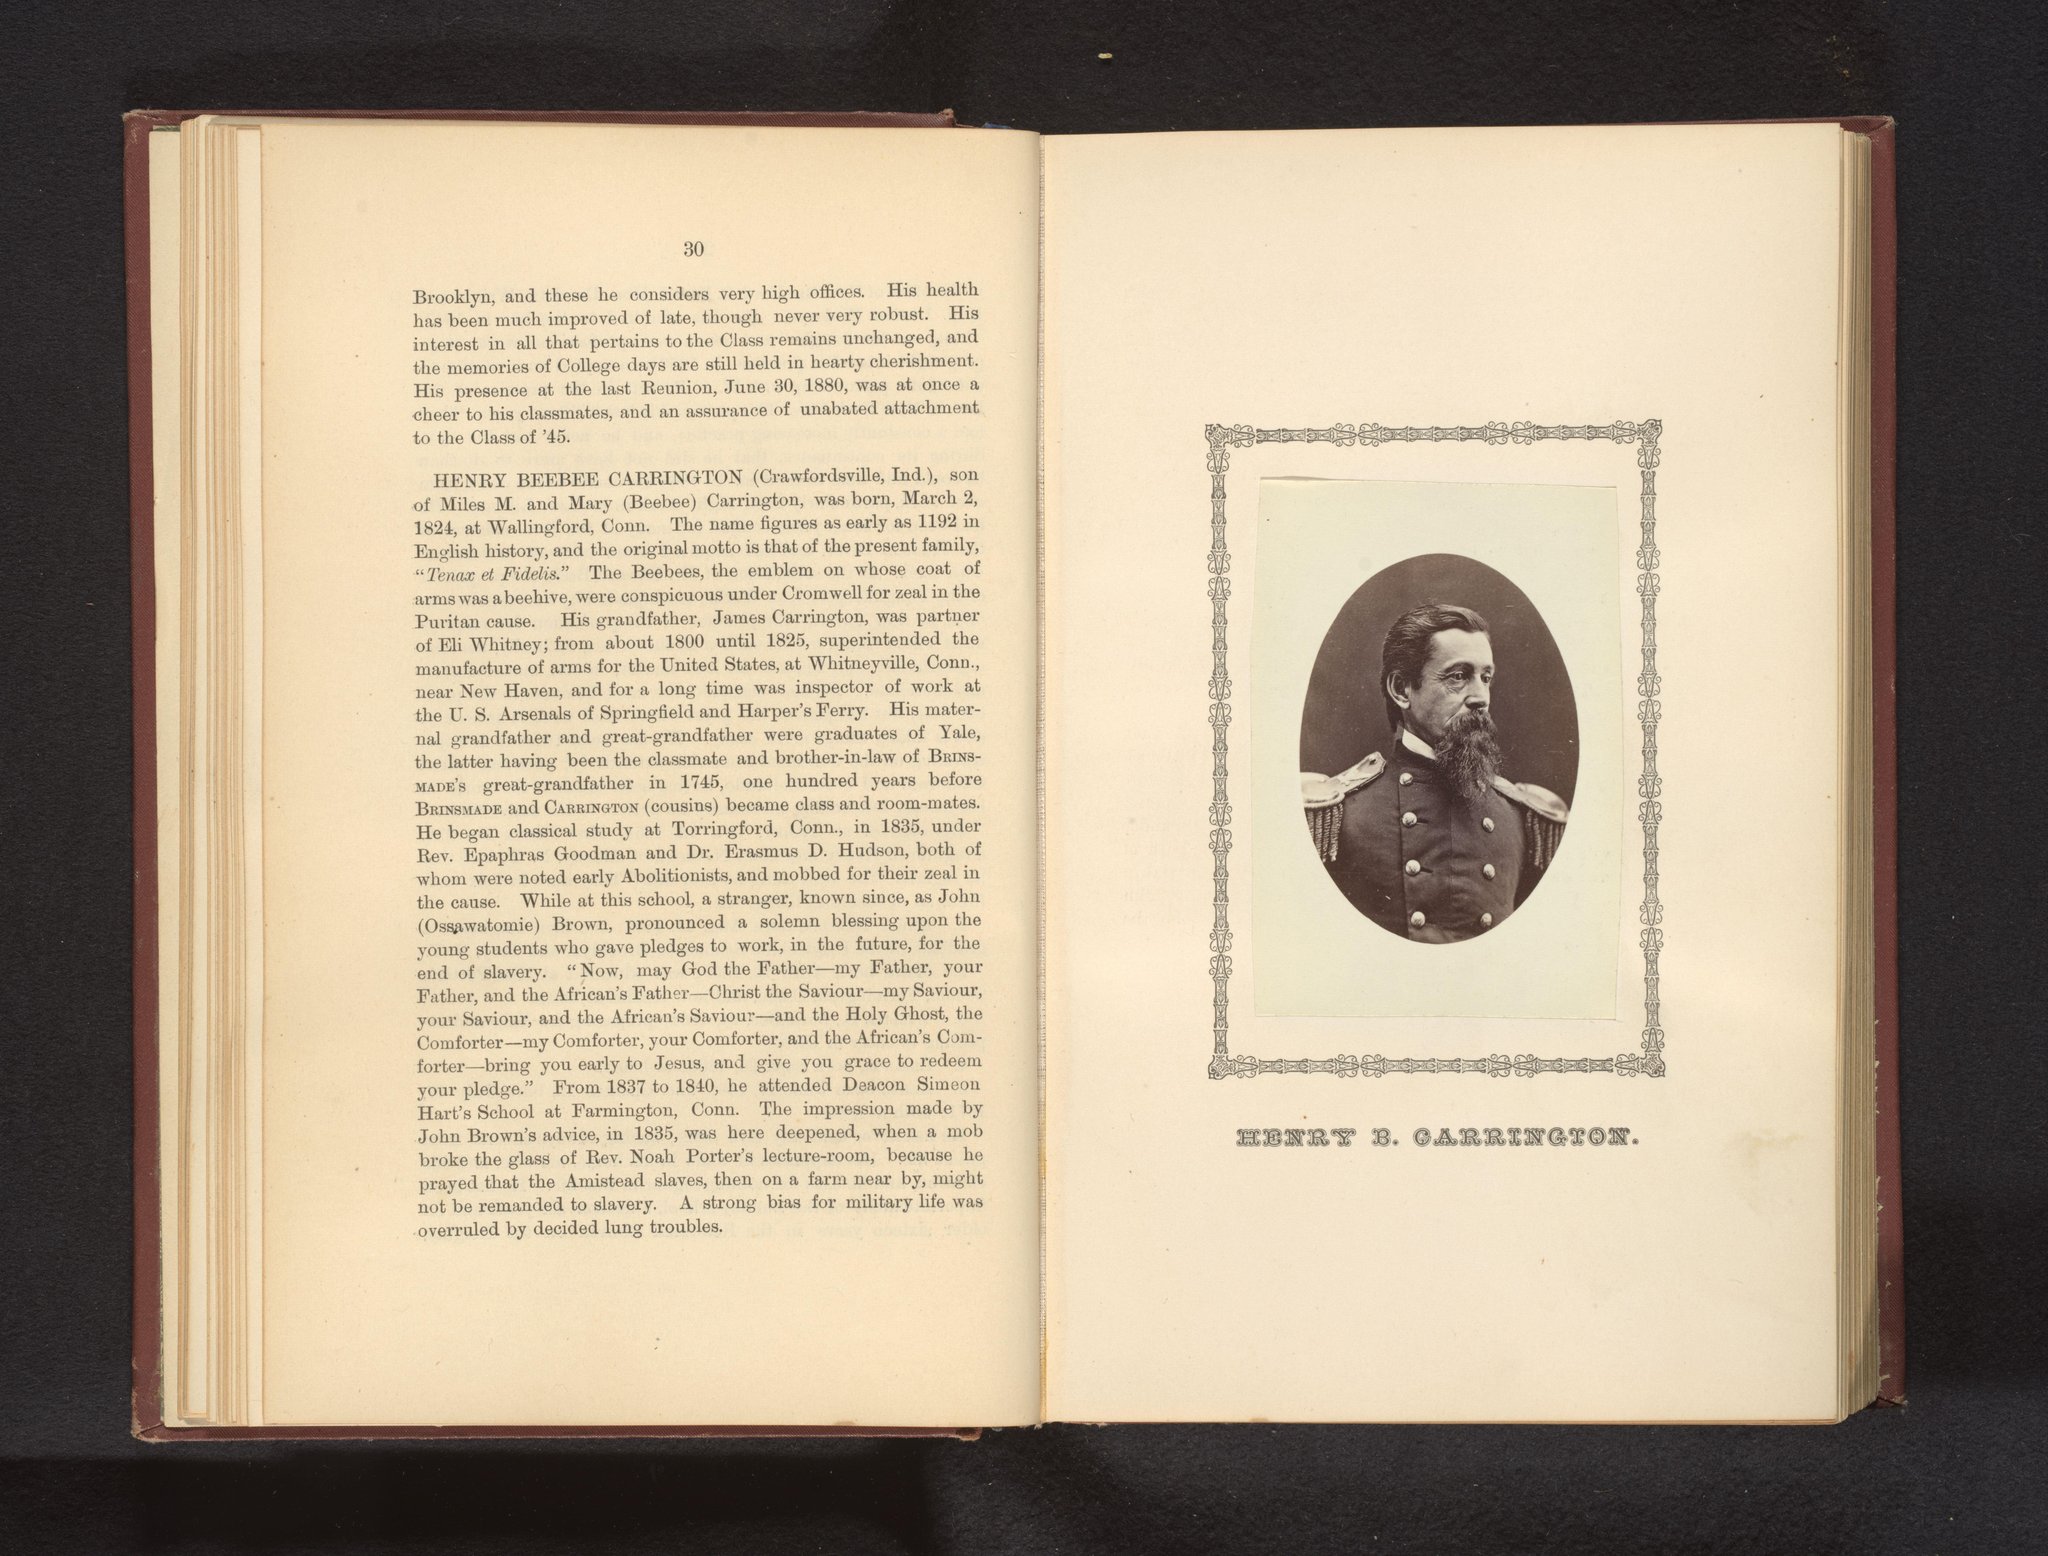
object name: photograph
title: Henry B. Carrington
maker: Anonymous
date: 1876-1881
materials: photographic support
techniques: albumen print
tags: lawyer, attorney at law